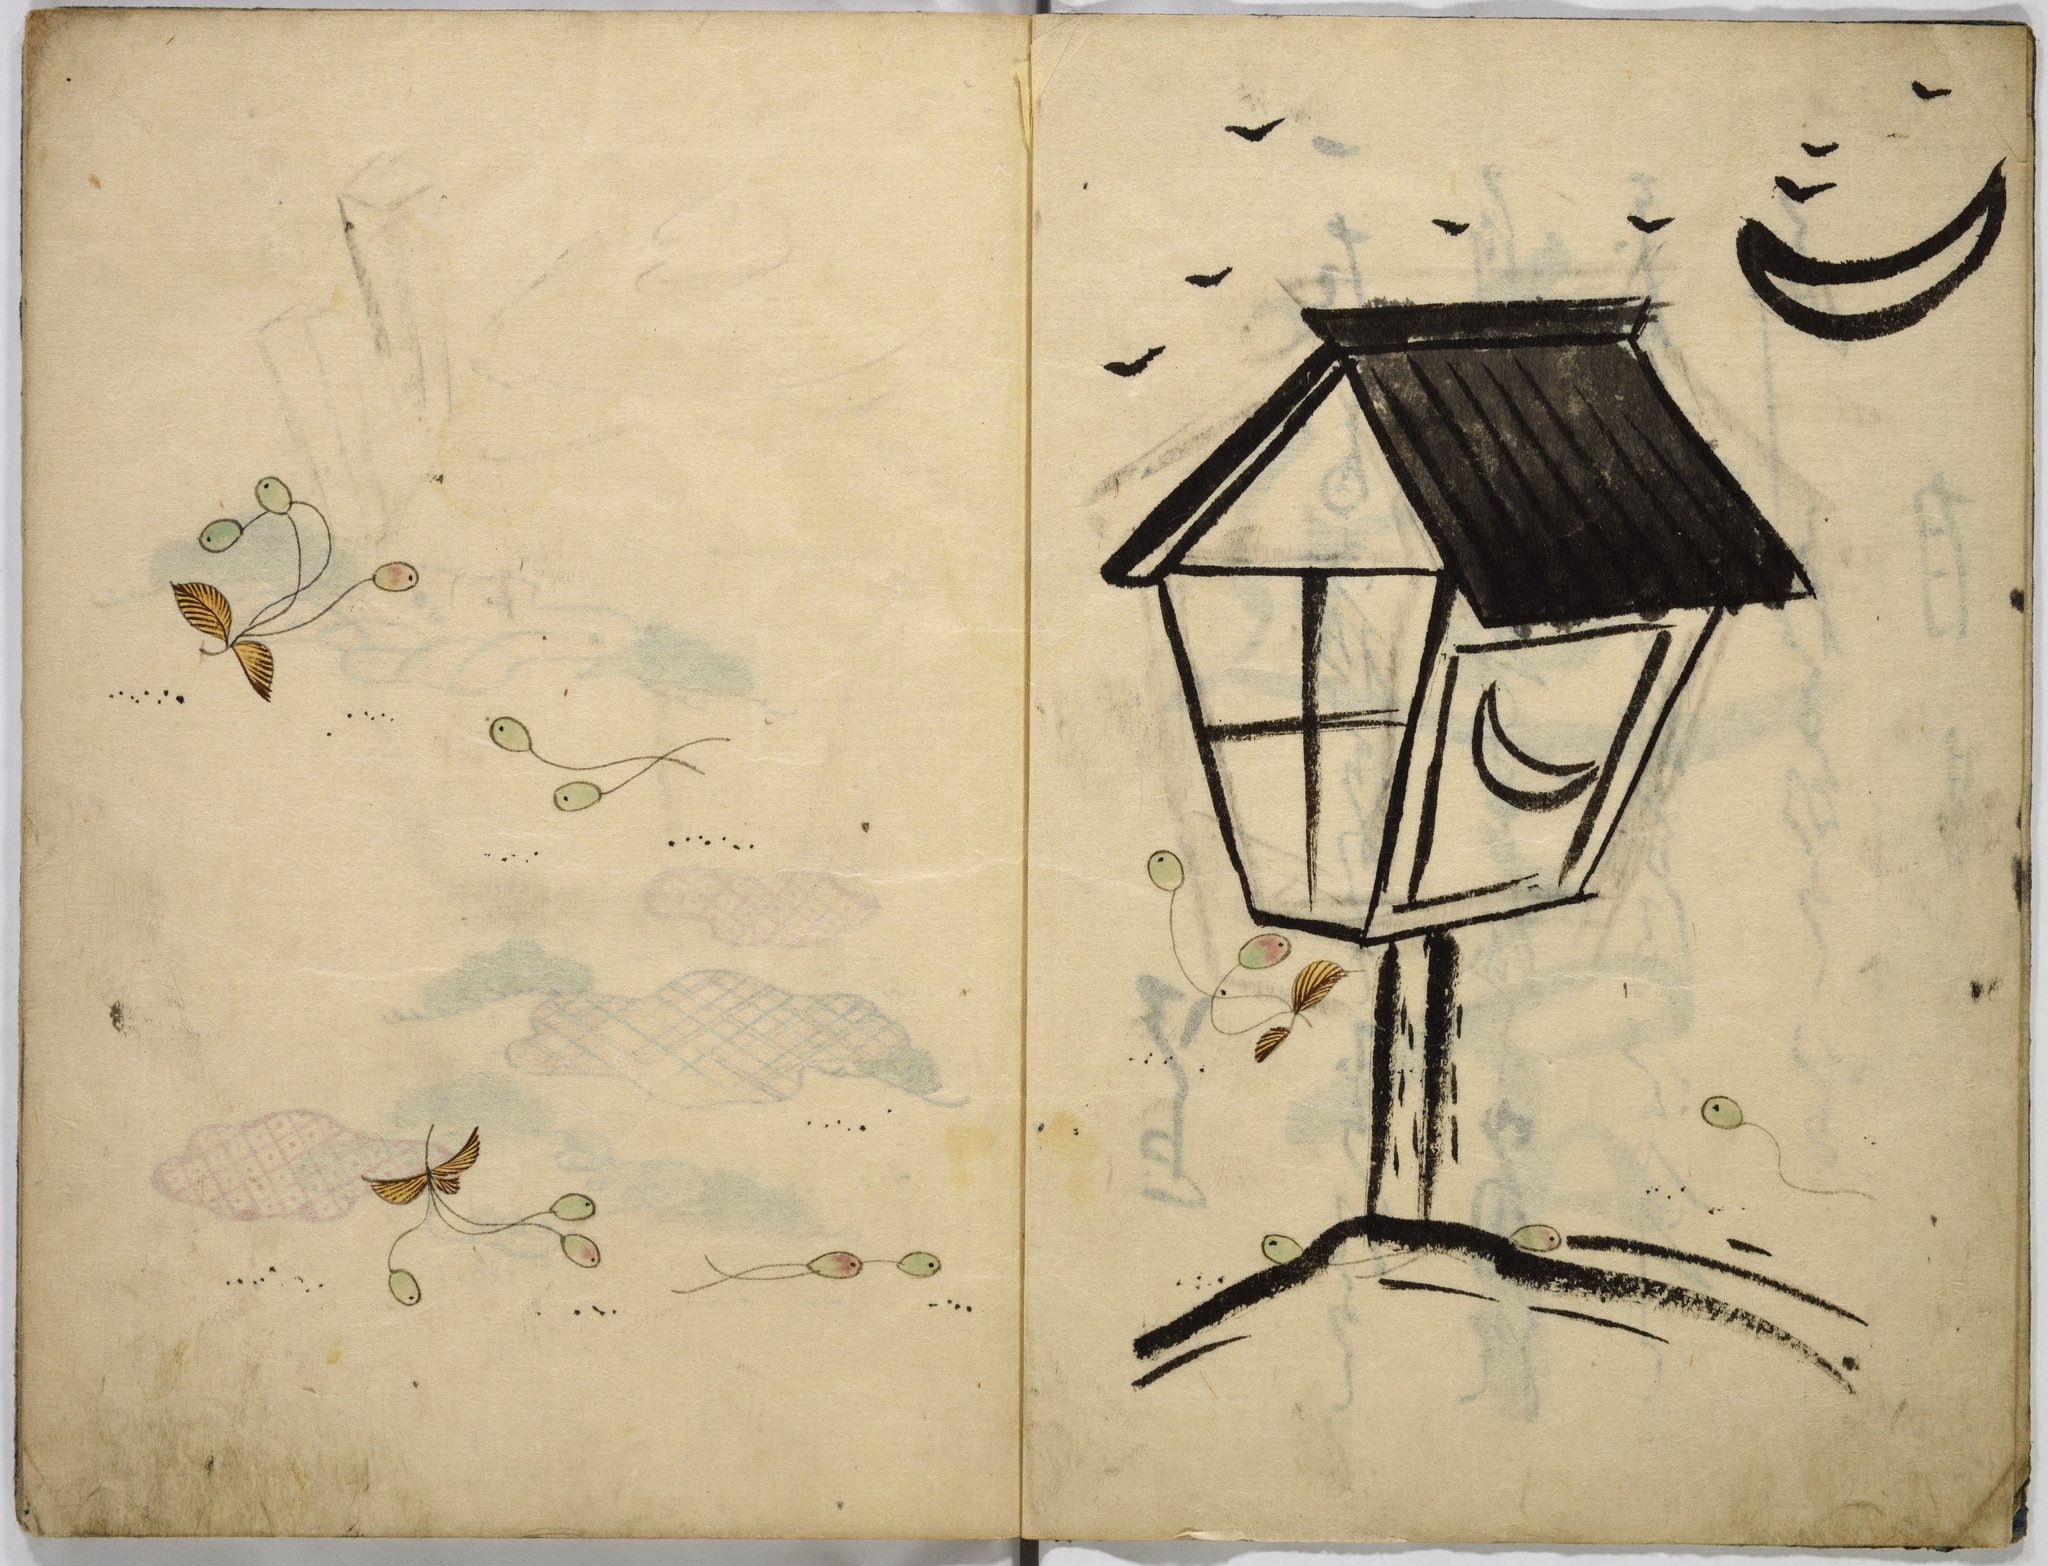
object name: illustrated book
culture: japanese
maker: unidentified artist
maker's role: artist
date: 1615-1868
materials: ink, paper, watercolor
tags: birds,houses,flowers